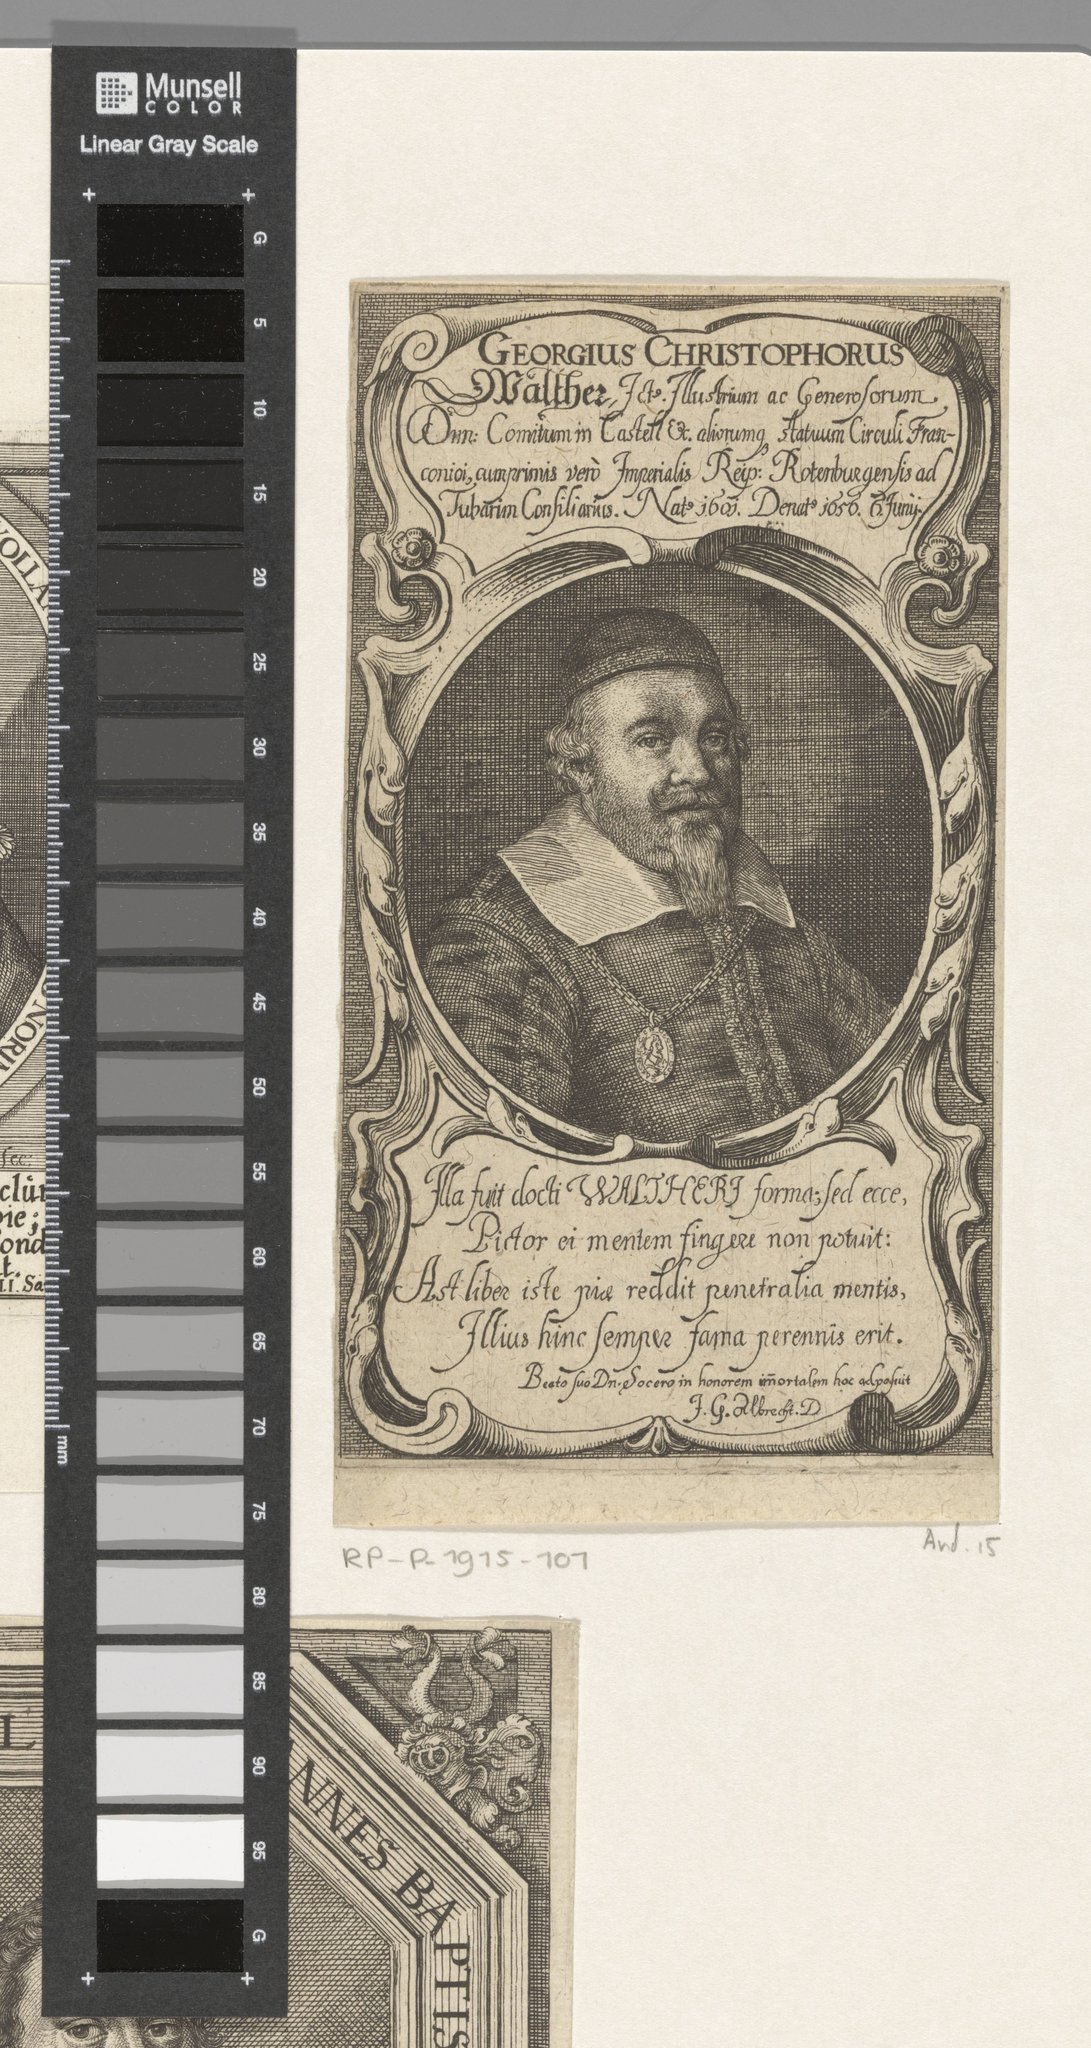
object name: print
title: Portret van Georg Christoph Walther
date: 1656-1675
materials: paper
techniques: etching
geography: nuremberg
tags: georg christoph walther (jurist), historical persons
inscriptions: collector's mark: Lugt 2228